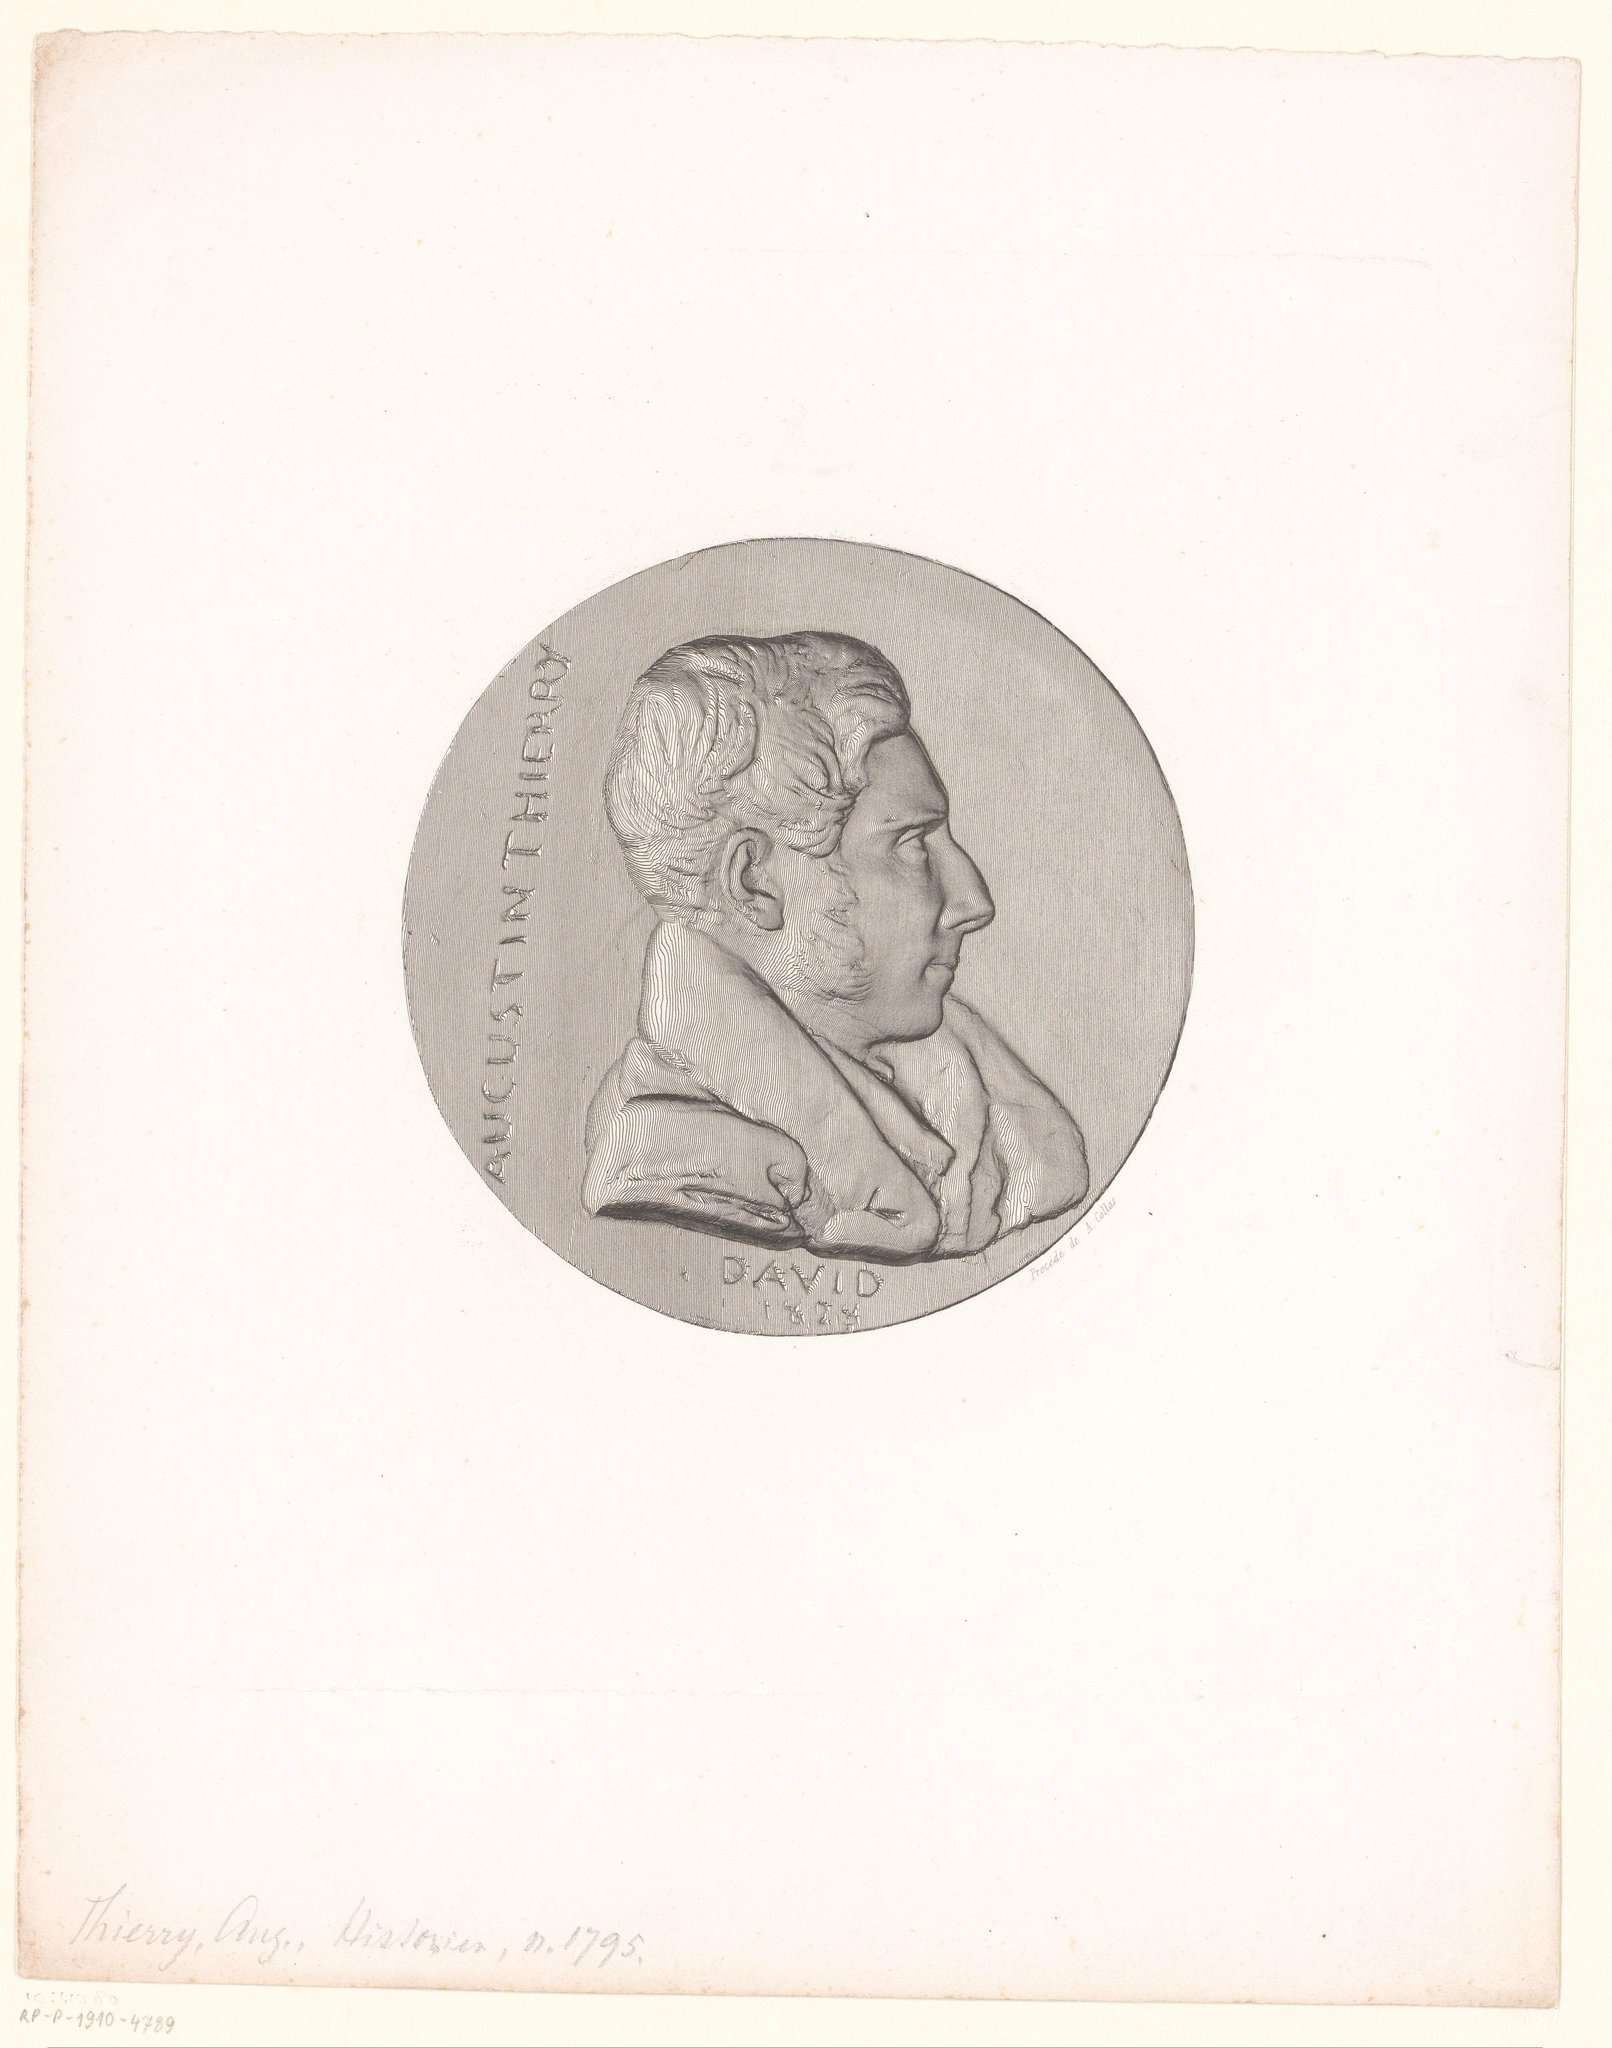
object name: print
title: Serie medaillons met vooraanstaande figuren uit het begin van de negentiende eeuw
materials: paper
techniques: relief engraving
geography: france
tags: paris, ornament ~ medallion, historical persons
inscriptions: collector's mark: Lugt 2228